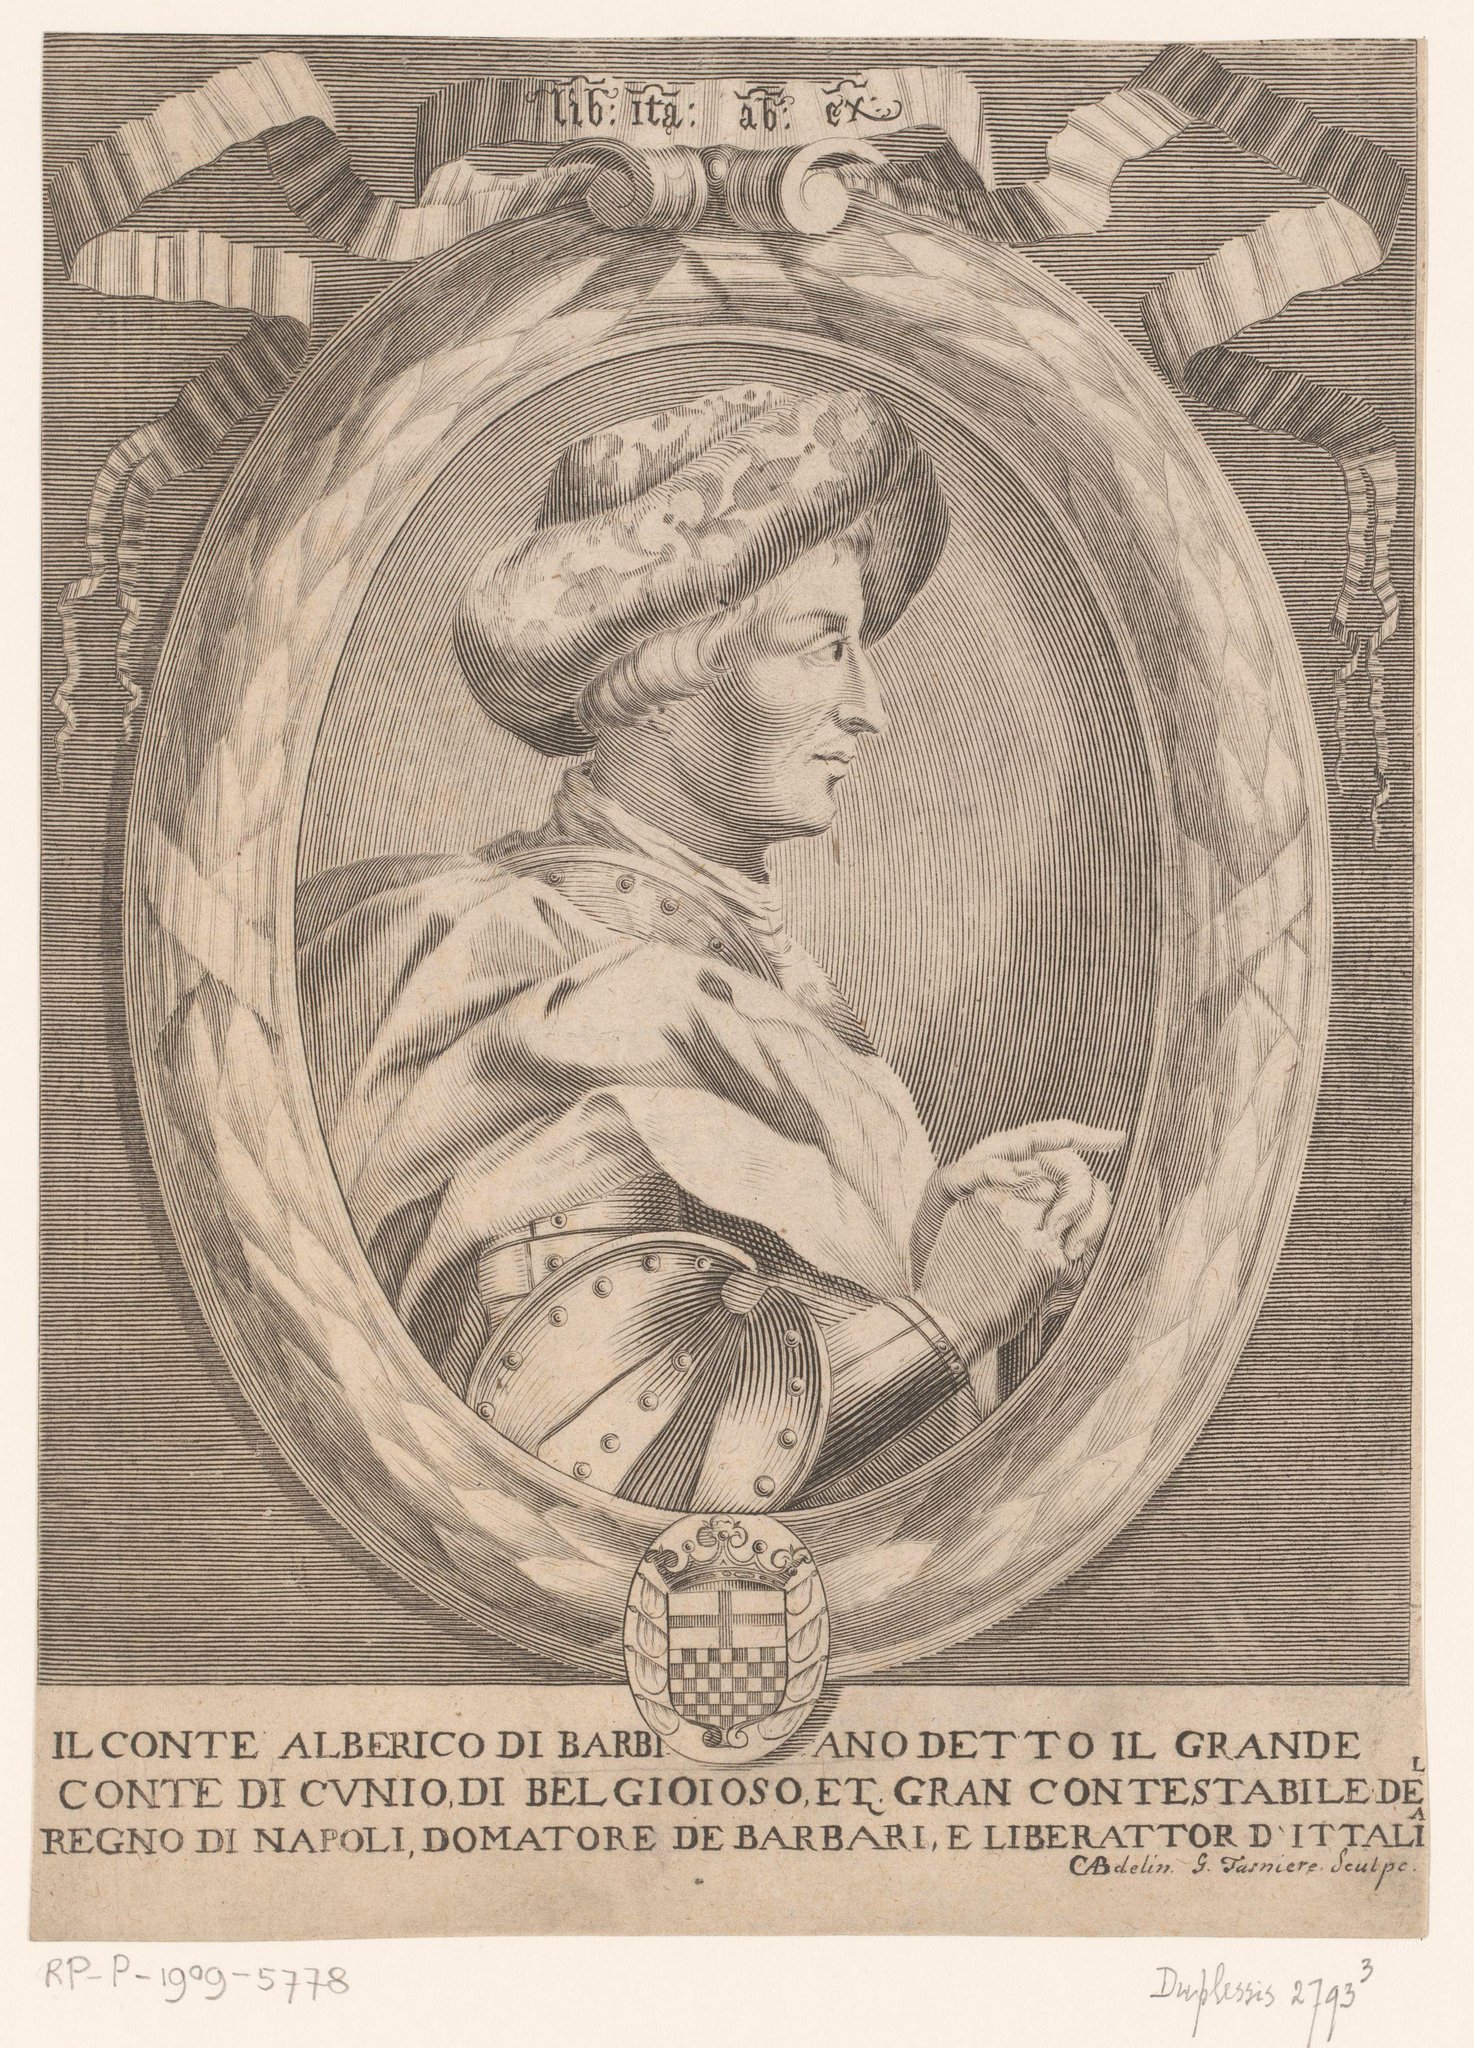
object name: print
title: Portret van Alberico da Barbiano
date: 1642-1704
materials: paper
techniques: engraving, etching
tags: historical persons (portraits and scenes from the life) (+ half-length portrait)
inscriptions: collector's mark: Lugt 2228